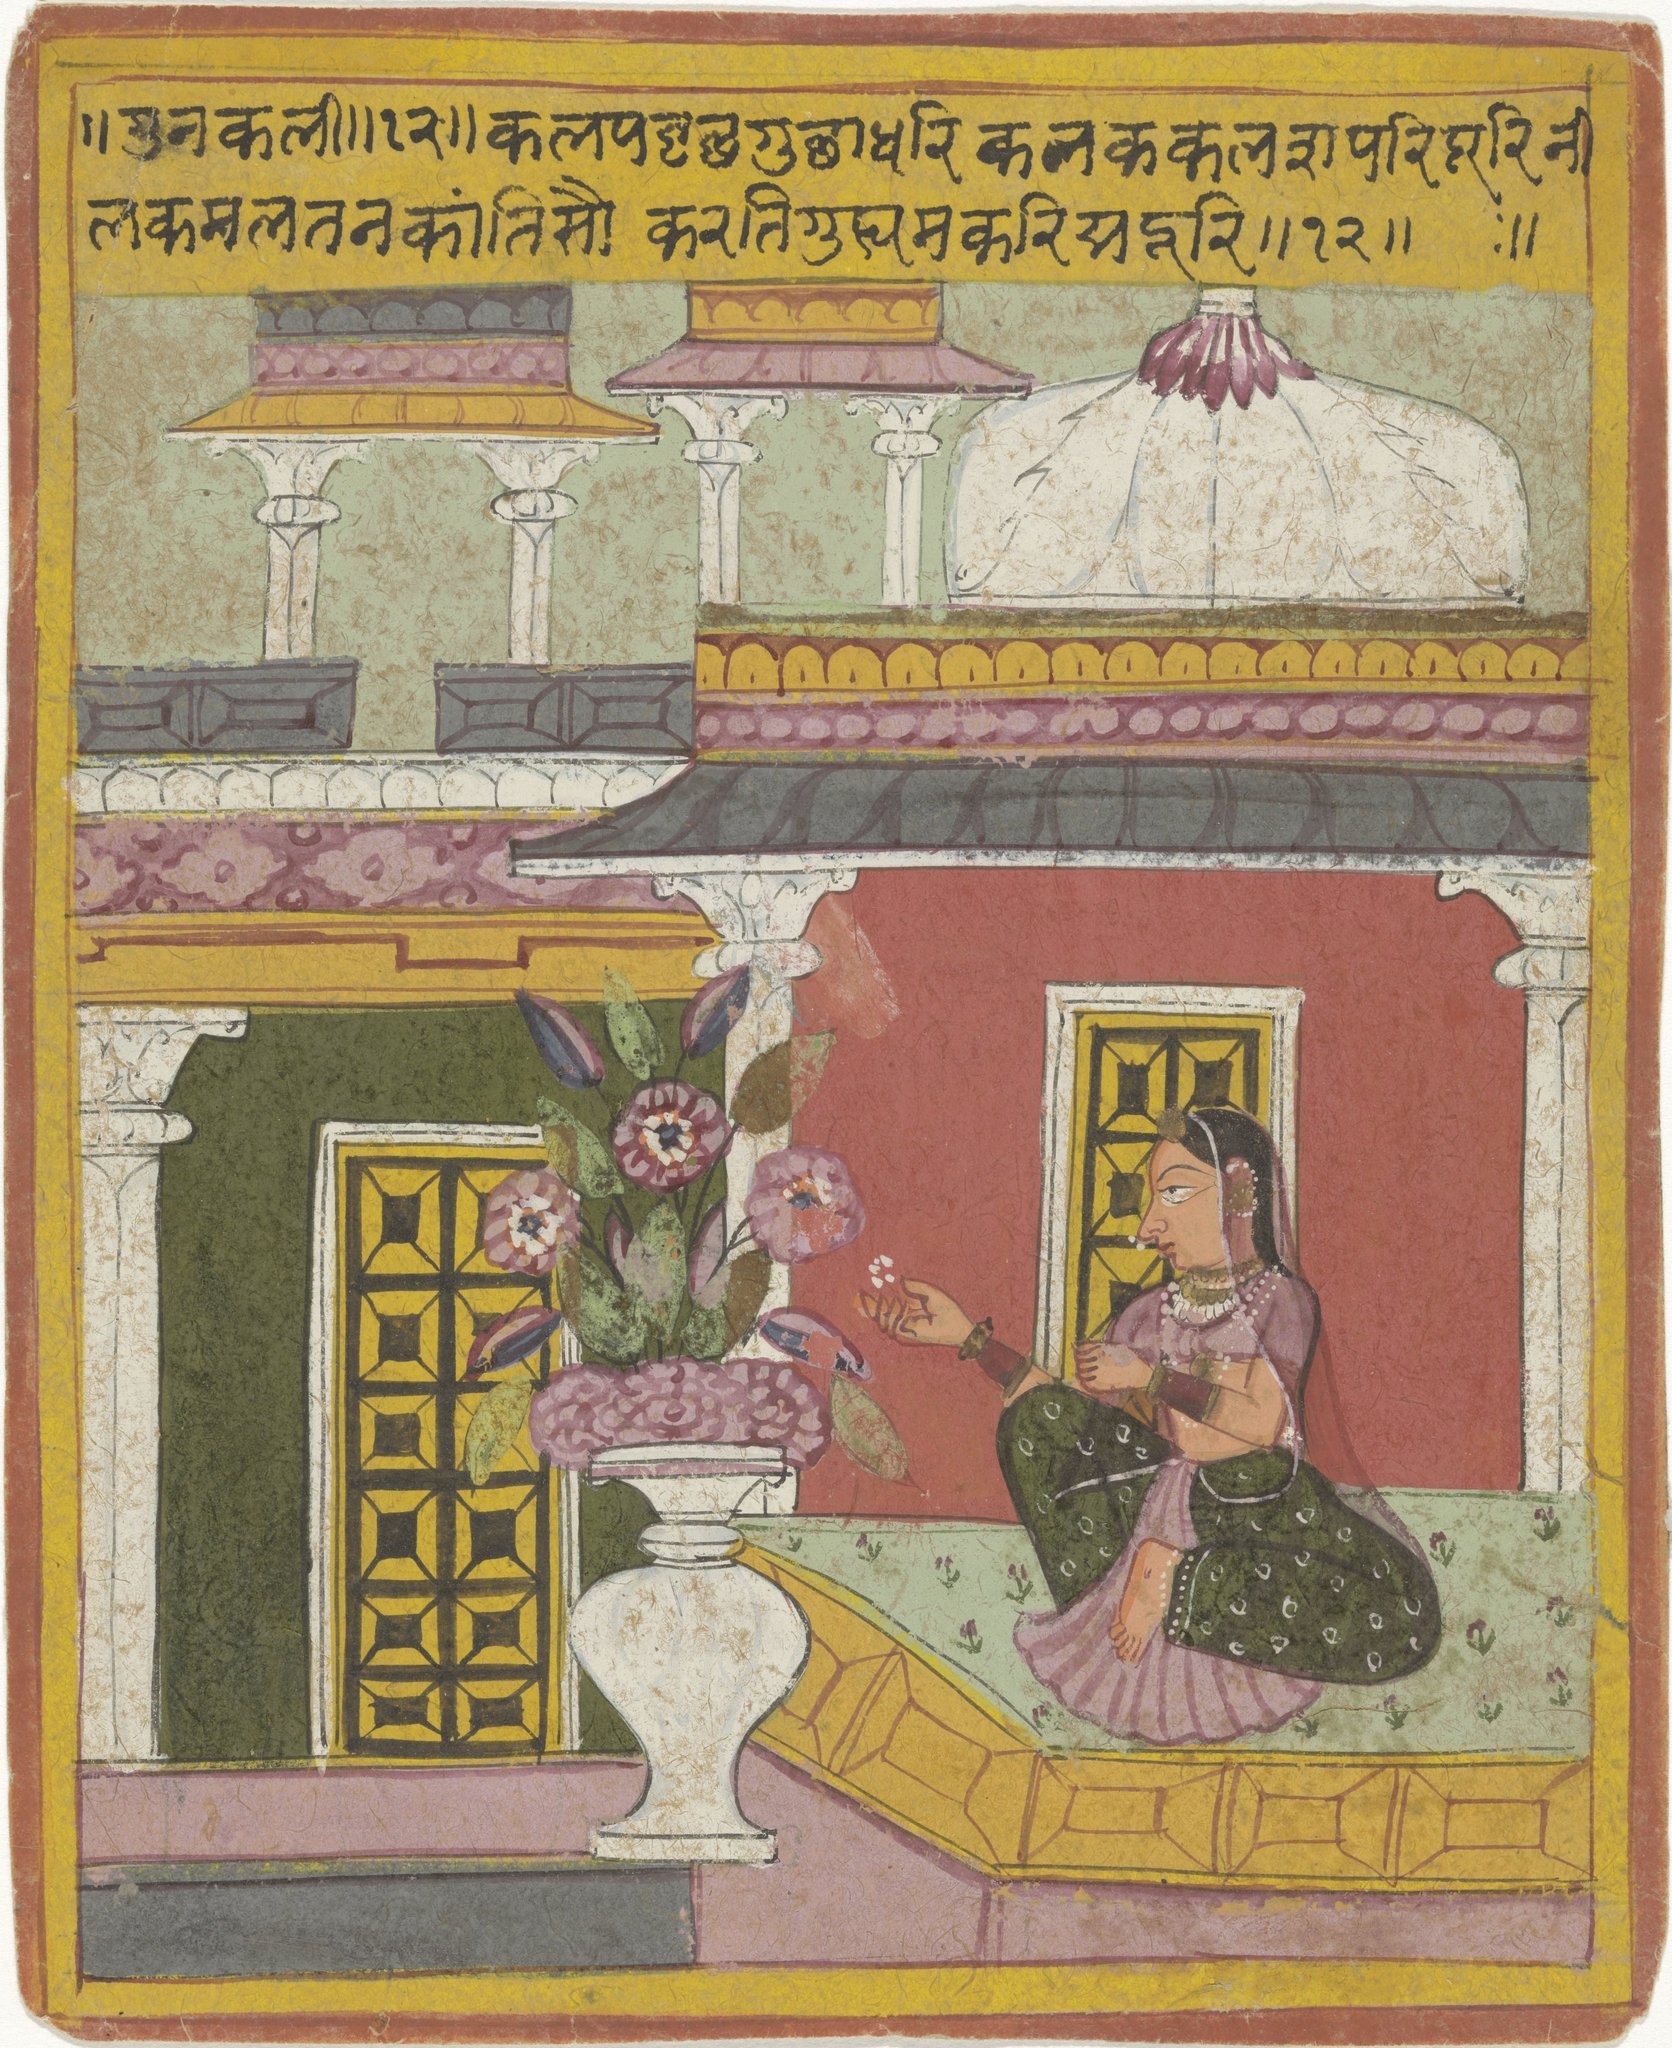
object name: indian miniature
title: Gunakali ragini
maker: Anonymous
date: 1690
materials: paper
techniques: brush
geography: sirohi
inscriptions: inscription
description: Op een overdekte veranda zit een vrouw op haar bed en plukt blaadjes van de bloemen die voor haar in een grote pot staan. Rond de voorstelling een smalle gele rand in rode kaderlijnen en een buitenste rand in rood met afgeronde hoeken; inscriptie boven de voorstelling in en brede gele strook.